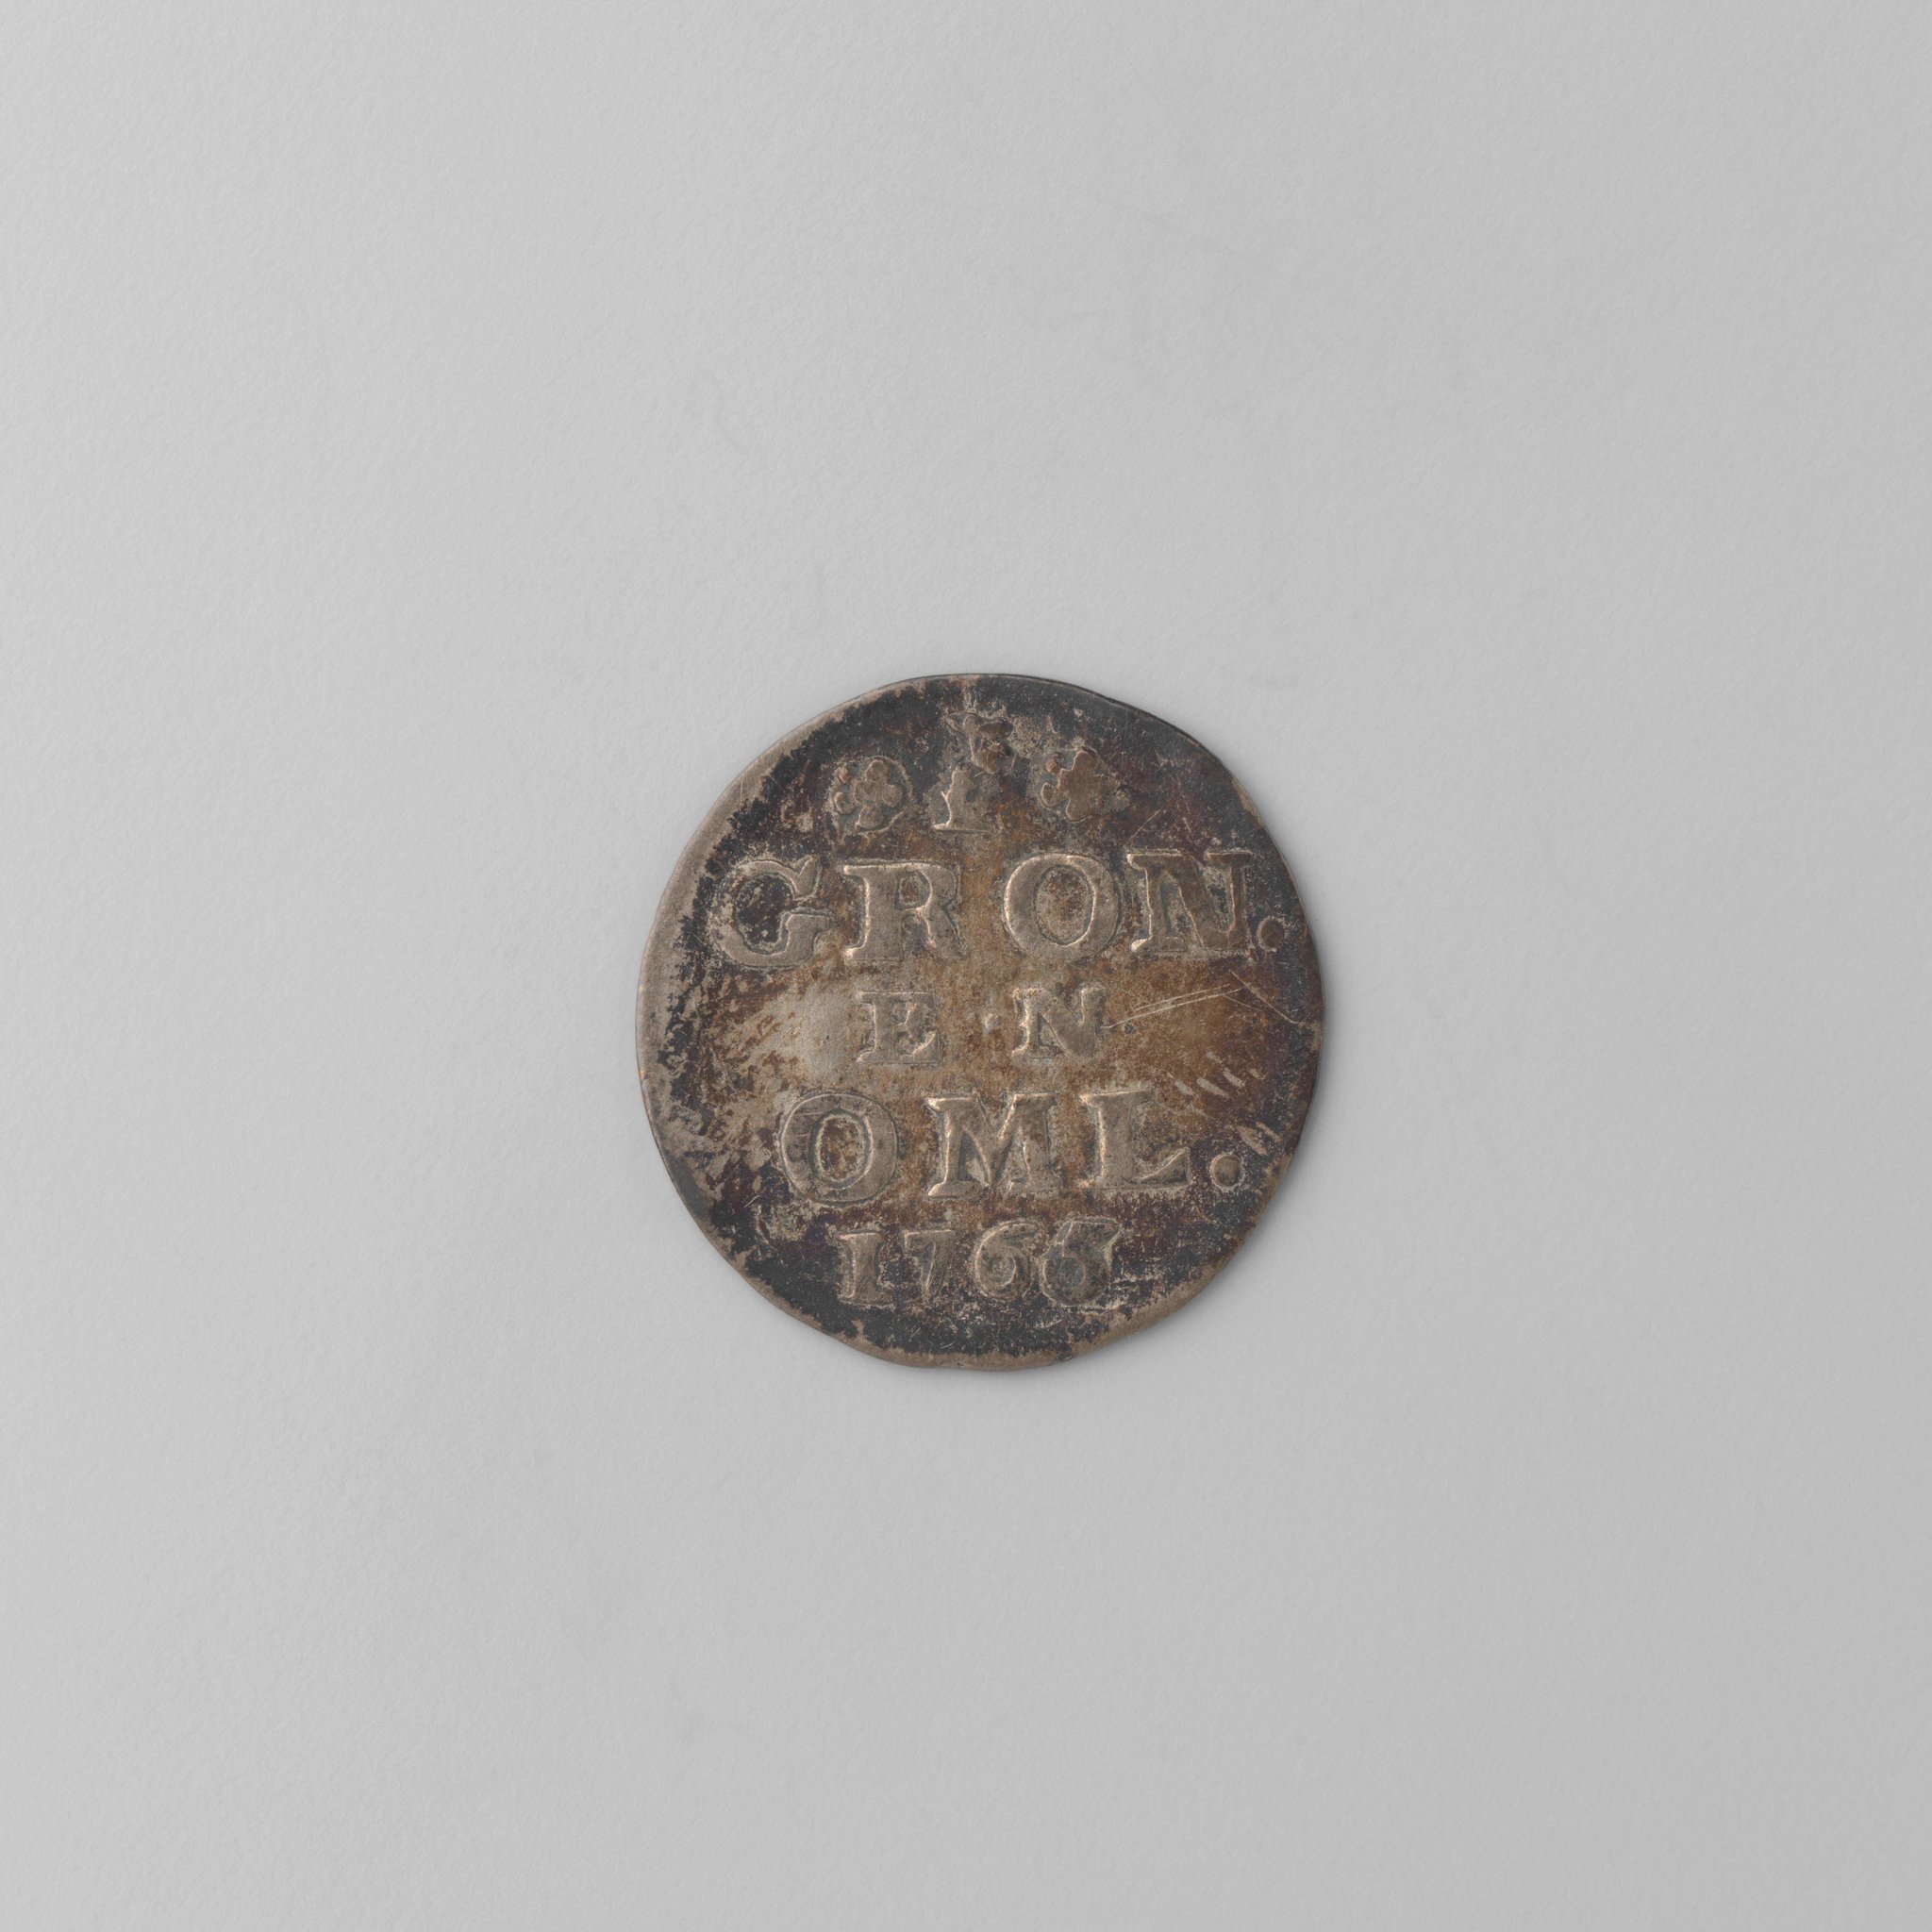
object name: coin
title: Stuiver van Groningen en de Ommelanden, 1765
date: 1765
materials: silver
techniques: striking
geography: harderwijk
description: Zilveren munt. Voorzijde: binnen lauwerkrans tussen pijlenbundel waarde-aanduiding 1 S. Keerzijde: twee-regelig opschrift, waarboven muntmeesterteken boompje van de muntmeester te Harderwijk en waaronder jaartal.